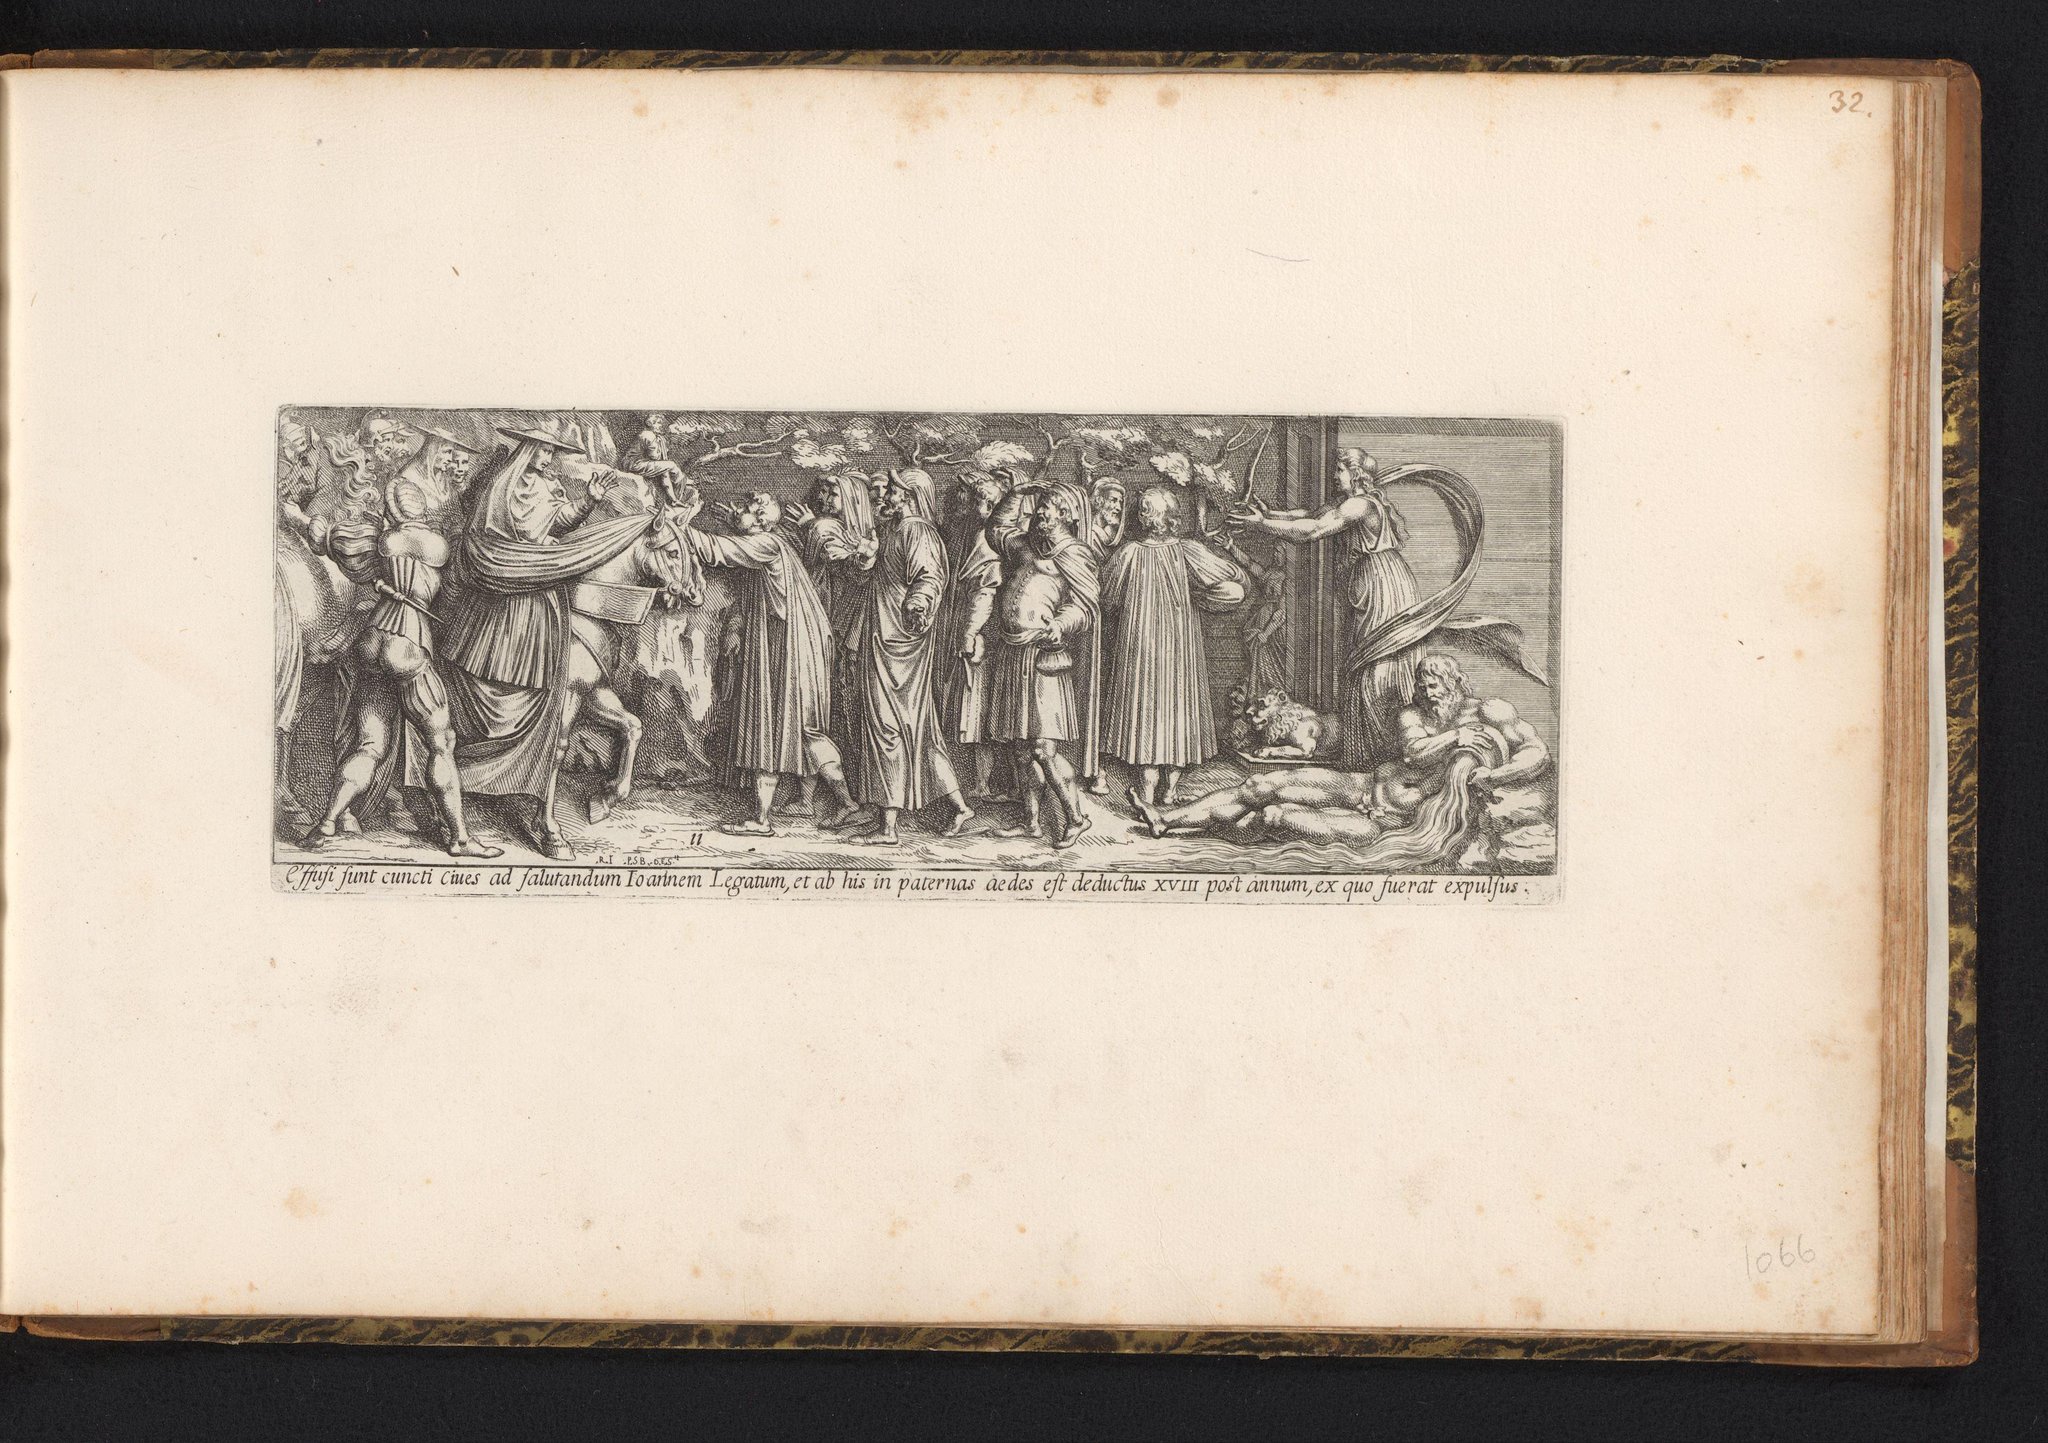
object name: album leaf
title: Scènes uit het leven van paus Leo X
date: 1645-1700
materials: paper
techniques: engraving, etching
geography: vatican city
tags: rome, leo x, arrival and return ~ travelling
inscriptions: number: ‘32’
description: Giovanni de' Medici gaat met zijn leger Florence binnen en wordt verwelkomd door een groep Florentijnen. Rechts een liggende riviergod. Titel in ondermarge. Genummerd midden onder: 11. Prent maakt deel uit van een album.